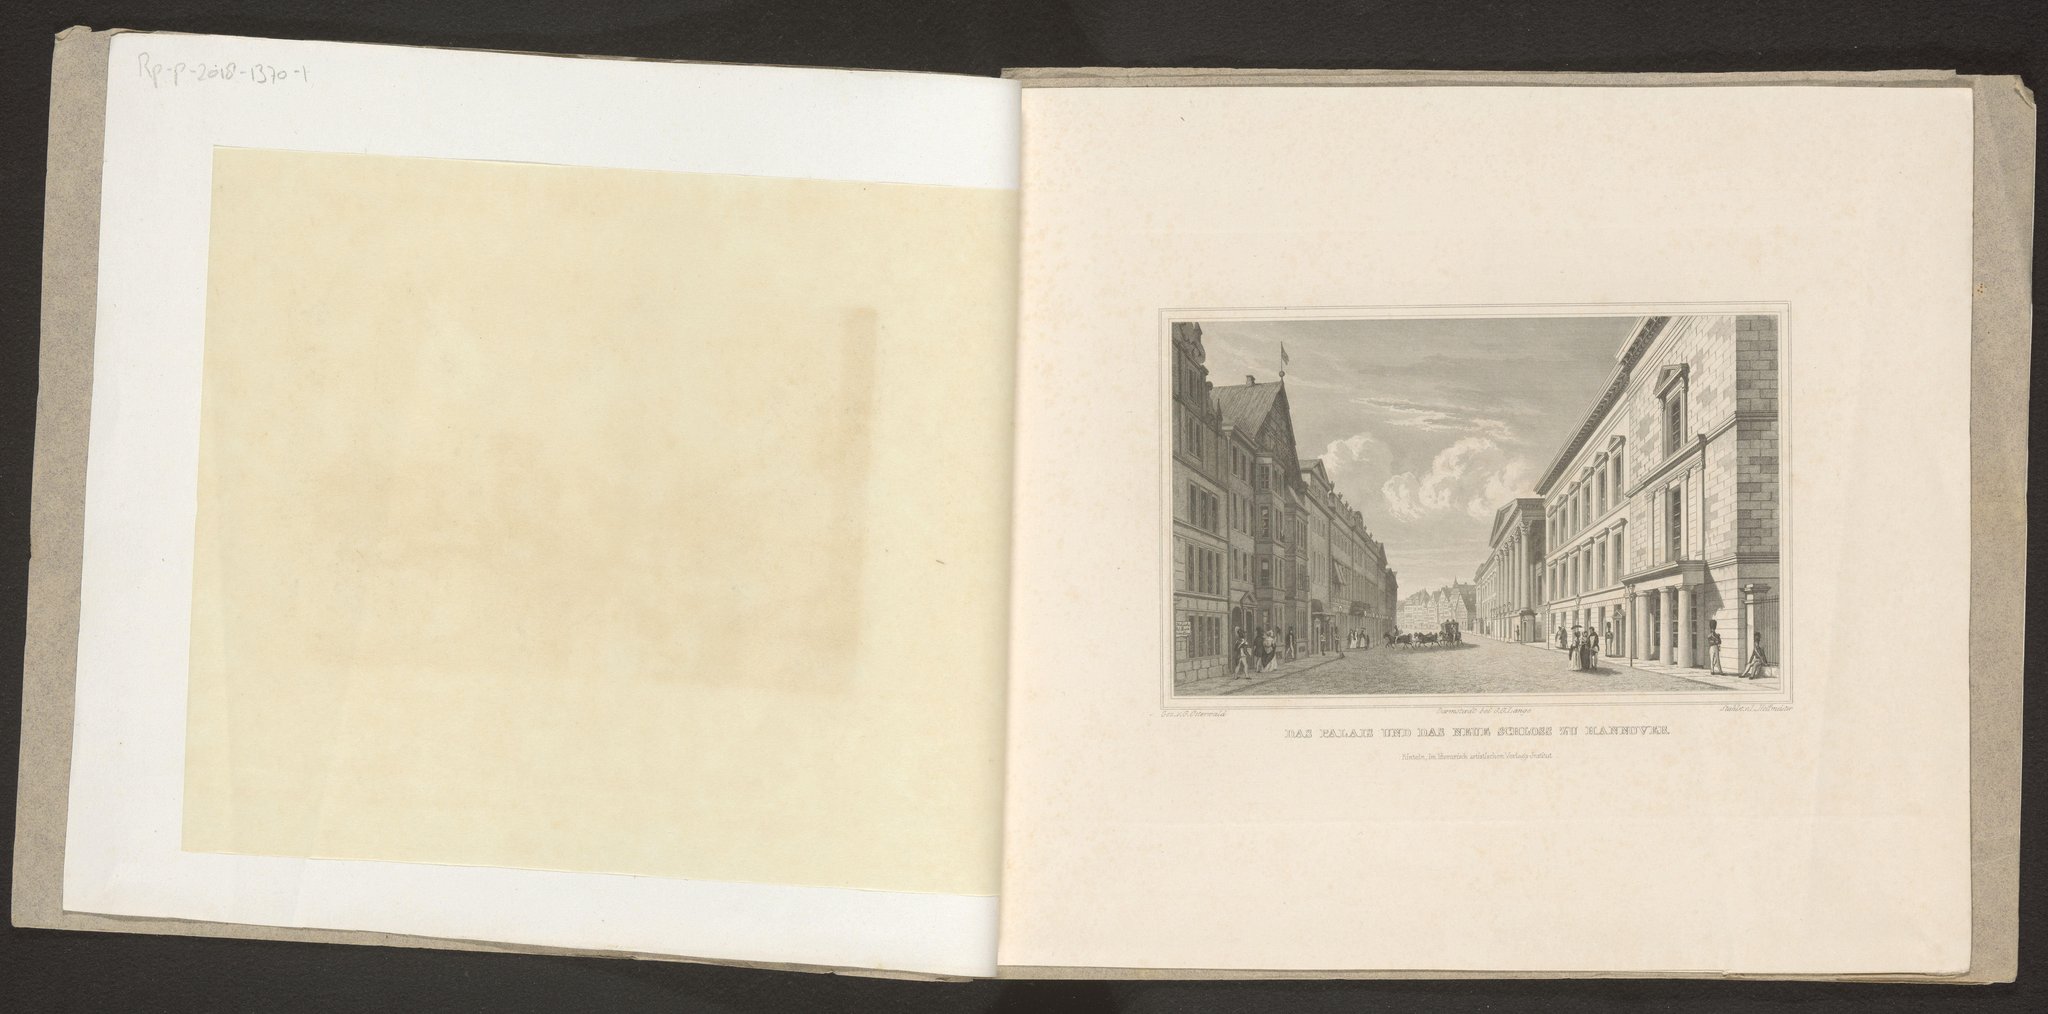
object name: print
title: Das Palais und das neue schloss zu Hannover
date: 1839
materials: paper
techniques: engraving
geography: rinteln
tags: palace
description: Deze prent maakt deel uit van een omslag met drie prenten.